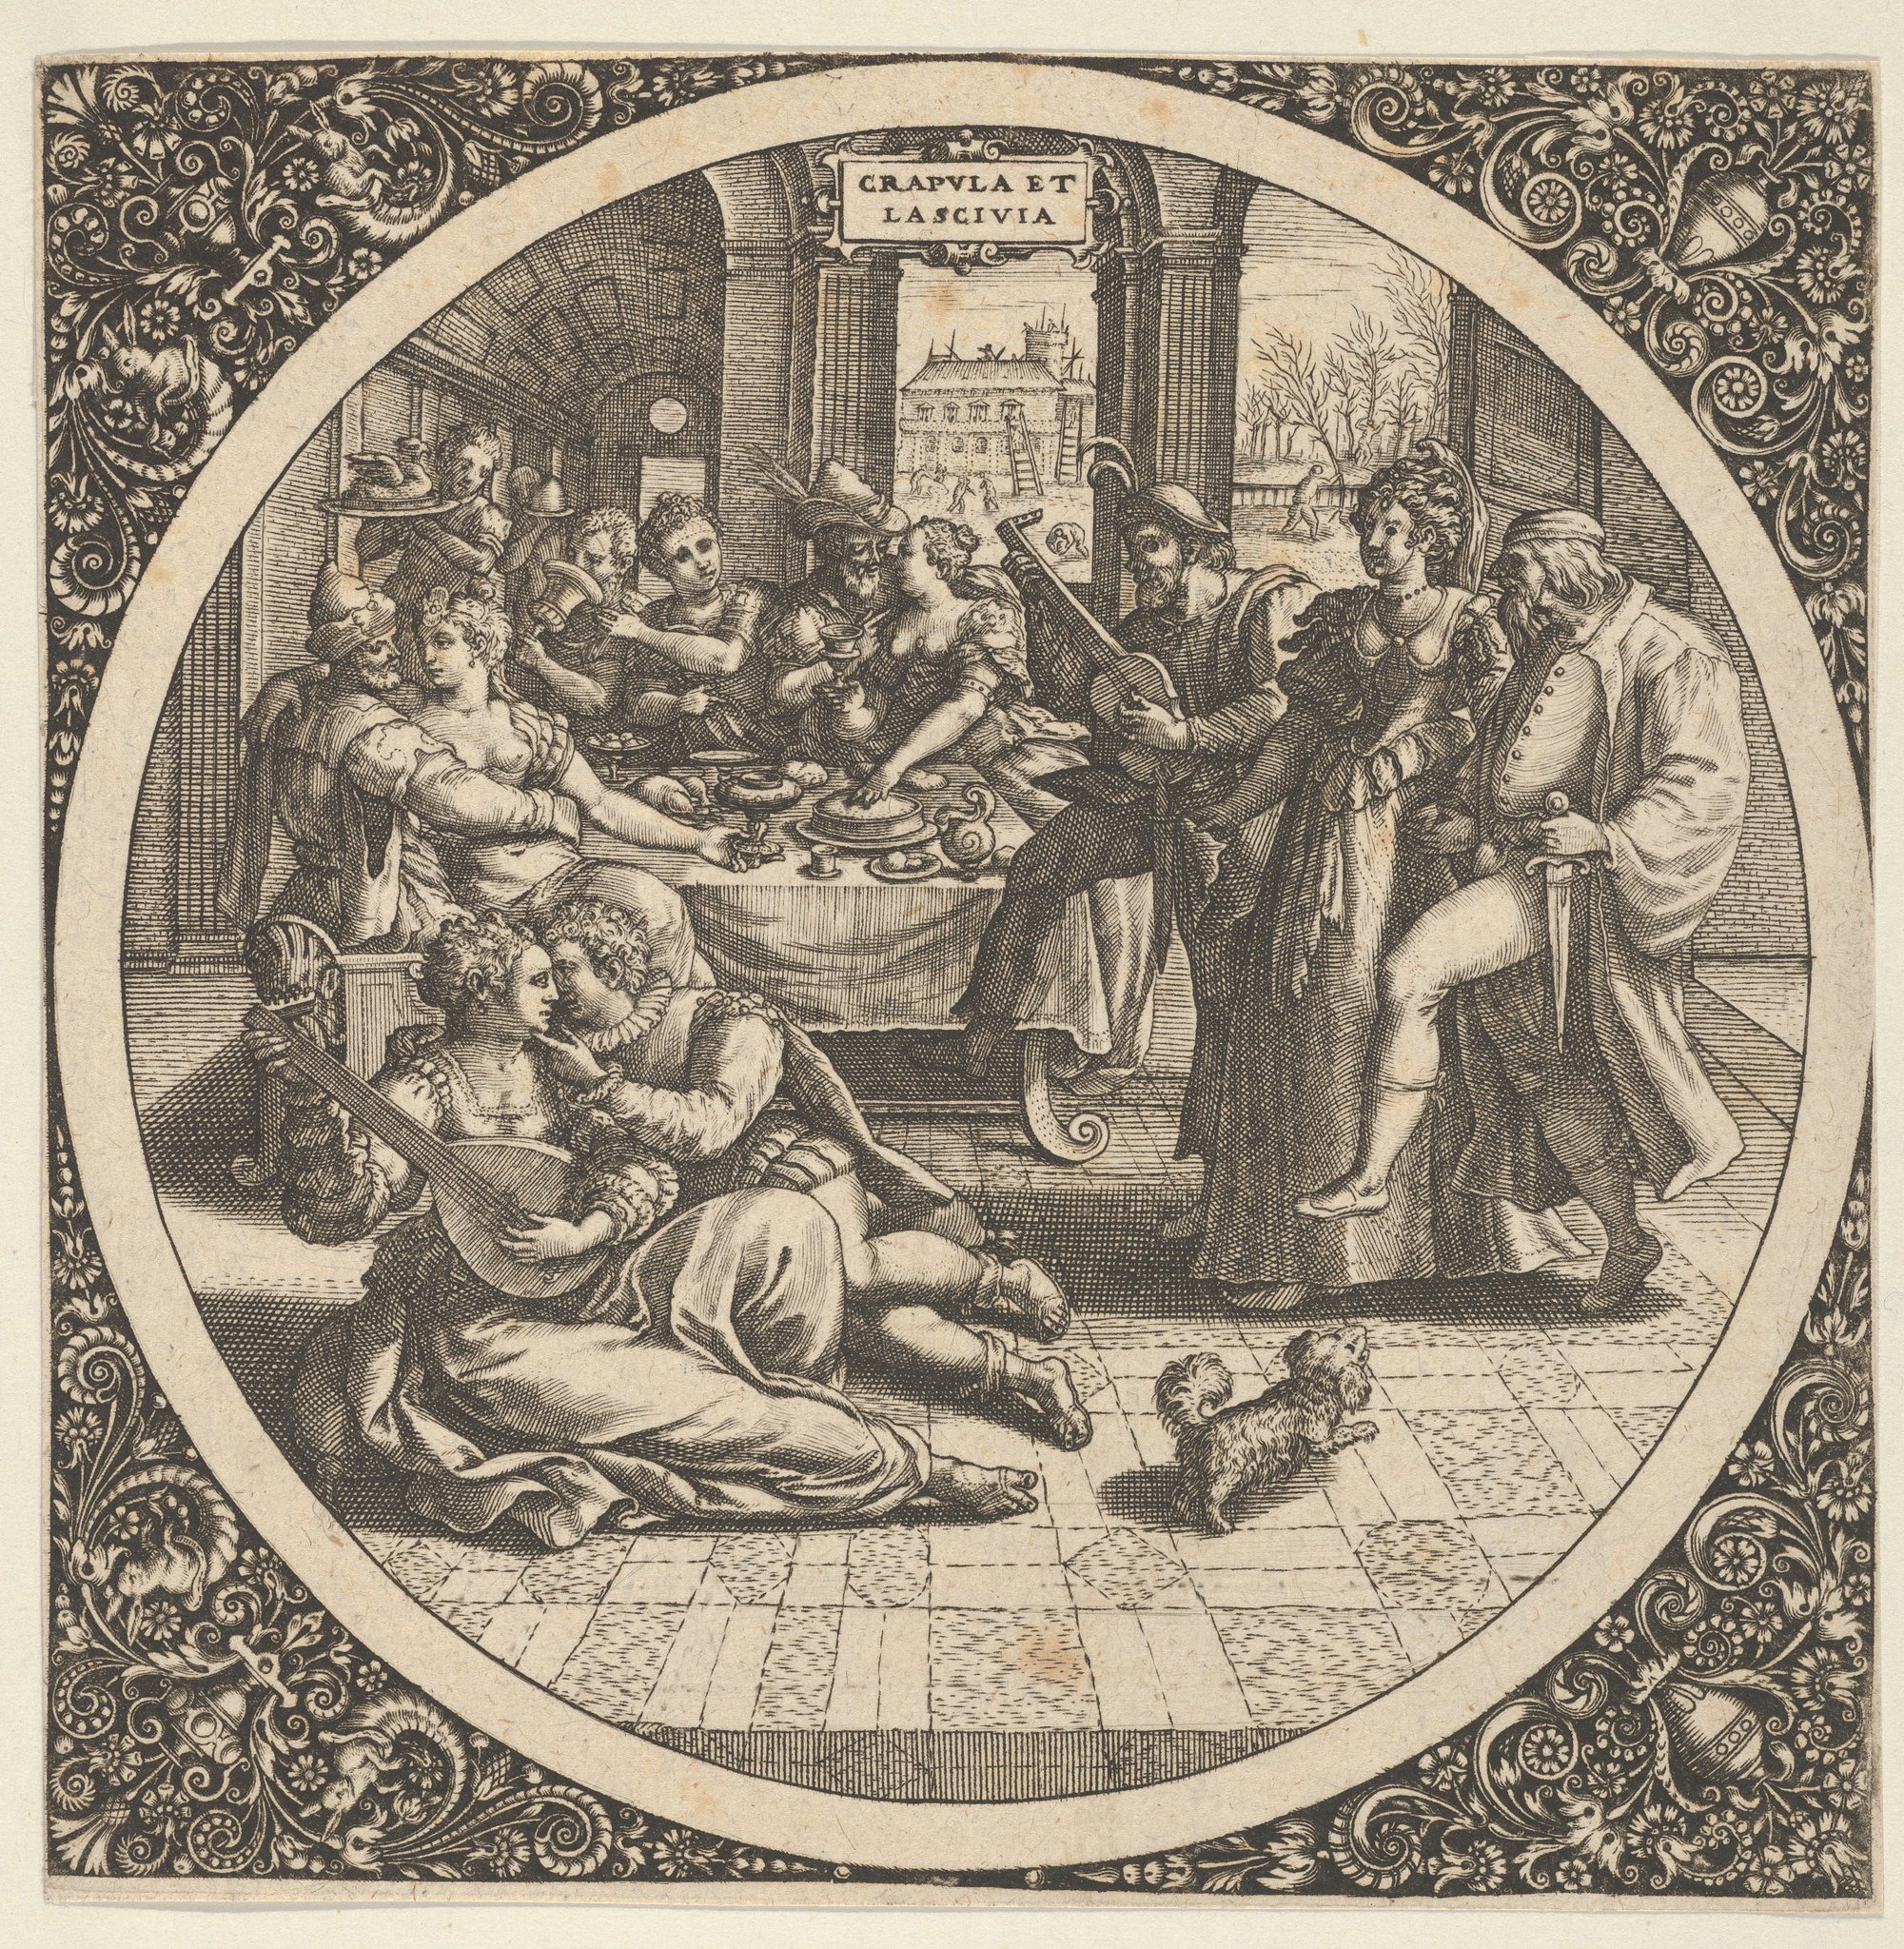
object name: print ornament architecture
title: Scene with Galants at a Banquet in a Circle at Center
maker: theodor de bry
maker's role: artist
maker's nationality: netherlandish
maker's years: 1528-1598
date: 1580-1600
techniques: embroidery, engraving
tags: food,couples,men,women,lutes,dogs,banquets